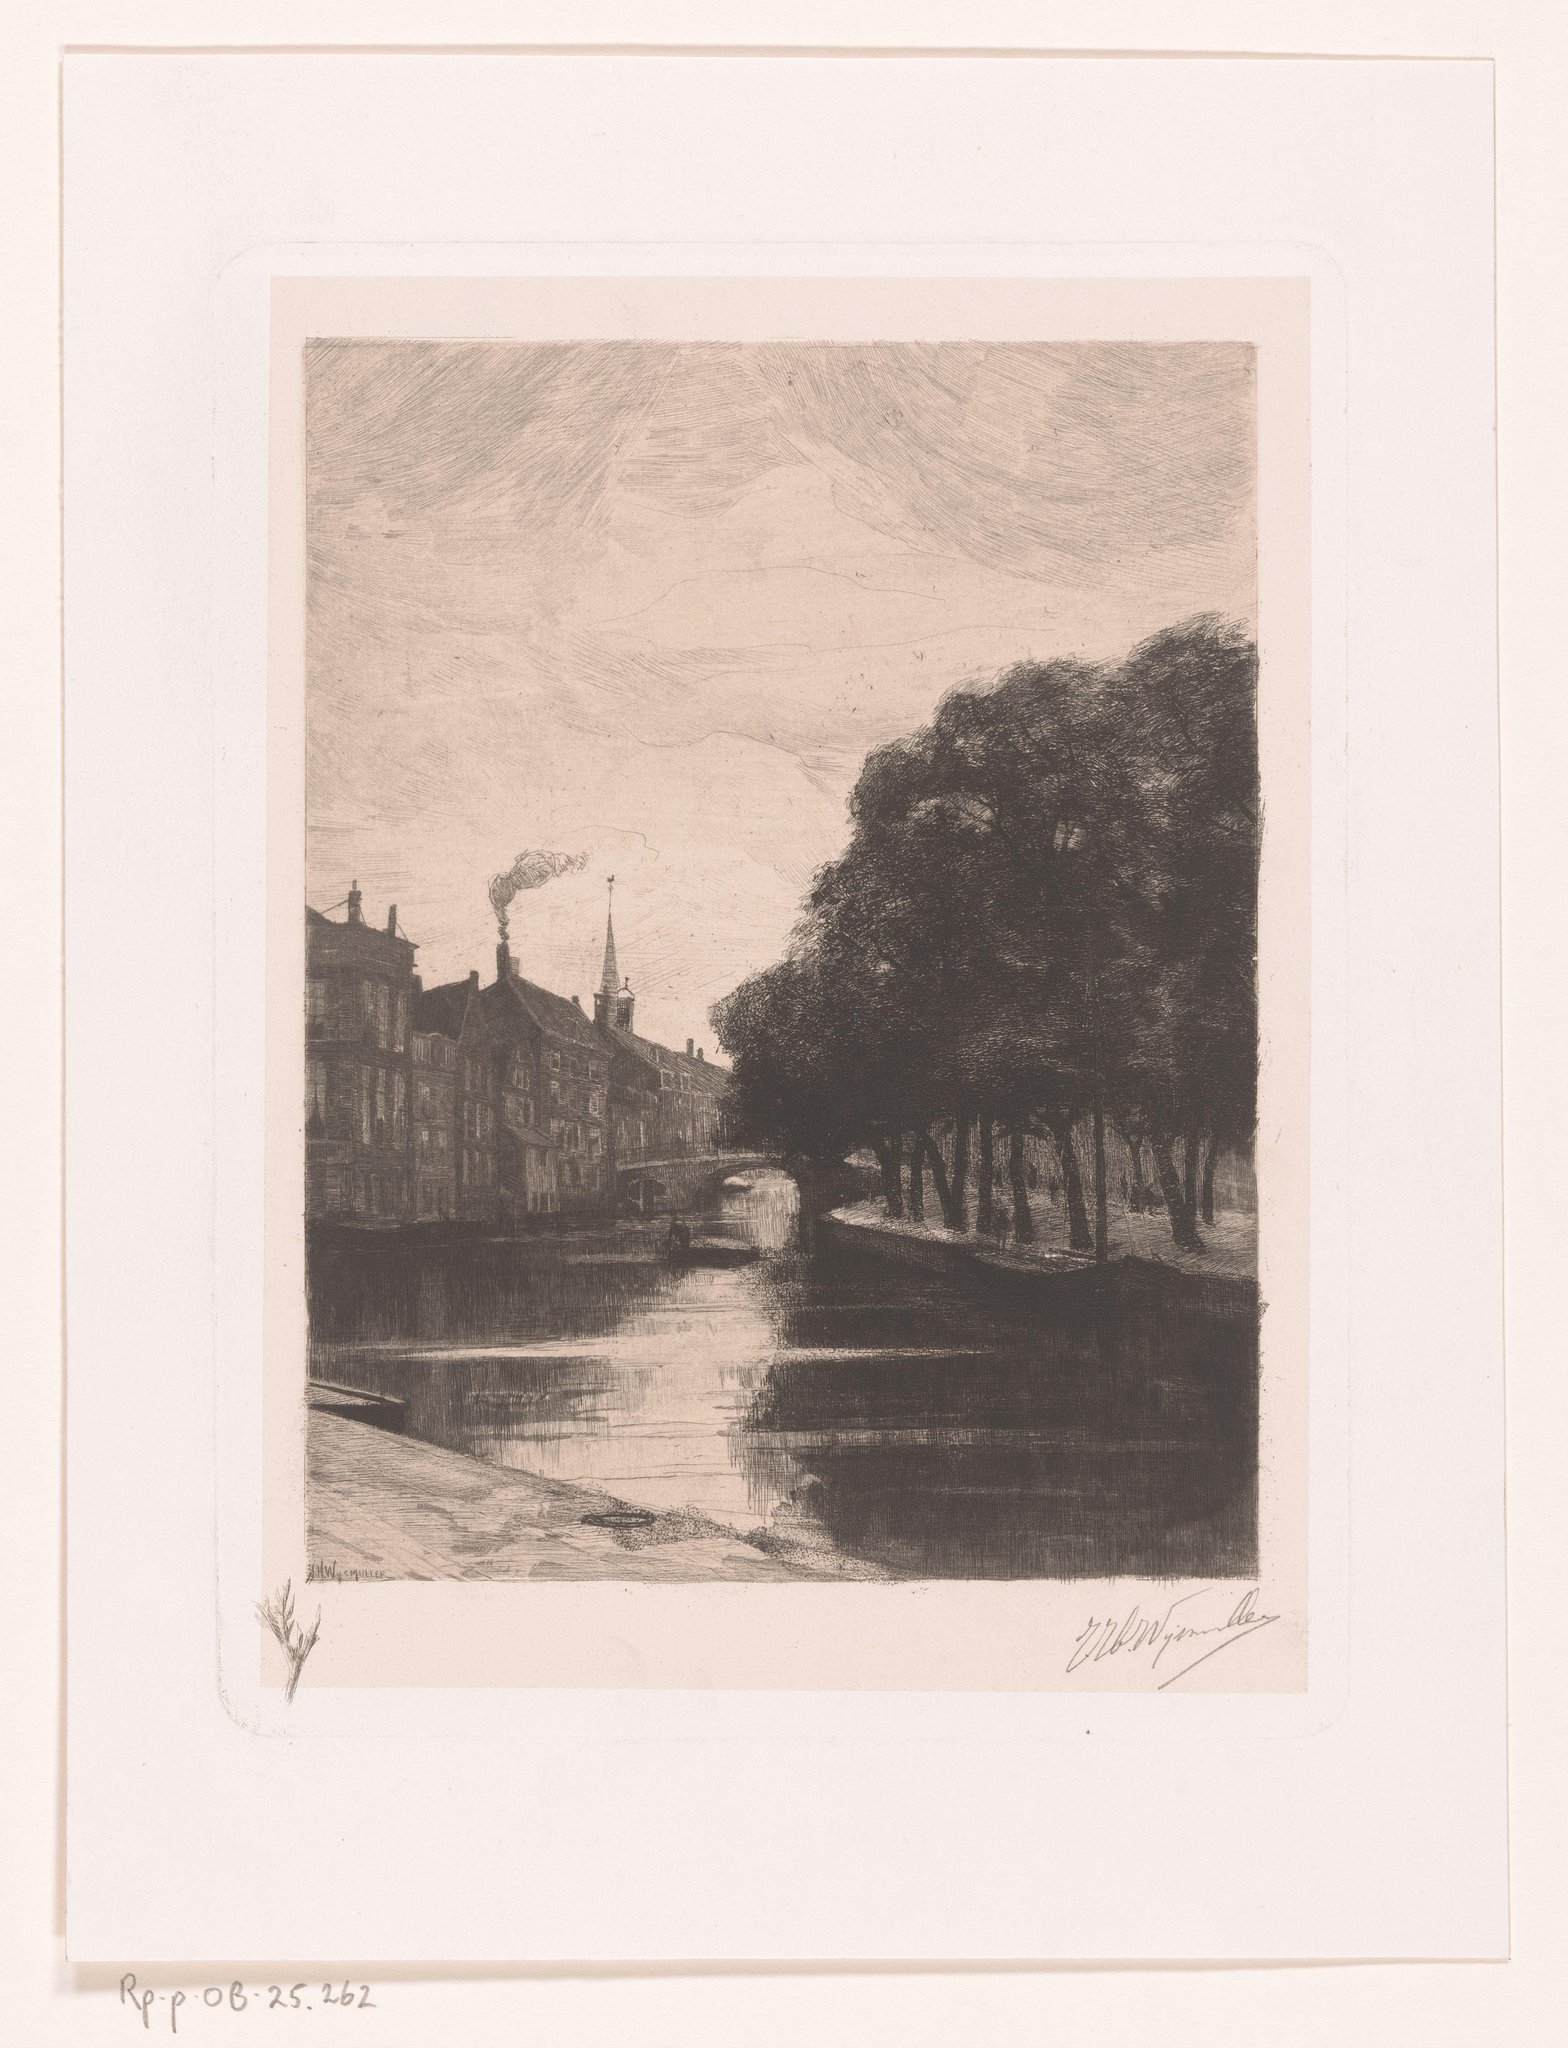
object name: print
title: Gezicht op de Nieuwezijds Voorburgwal, te Amsterdam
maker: jan hillebrand wijsmuller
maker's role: painter, print maker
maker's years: 1855-1925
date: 1865-1925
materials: paper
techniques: drypoint, etching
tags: canals, waters (in city)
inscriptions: collector's mark: Lugt 2228